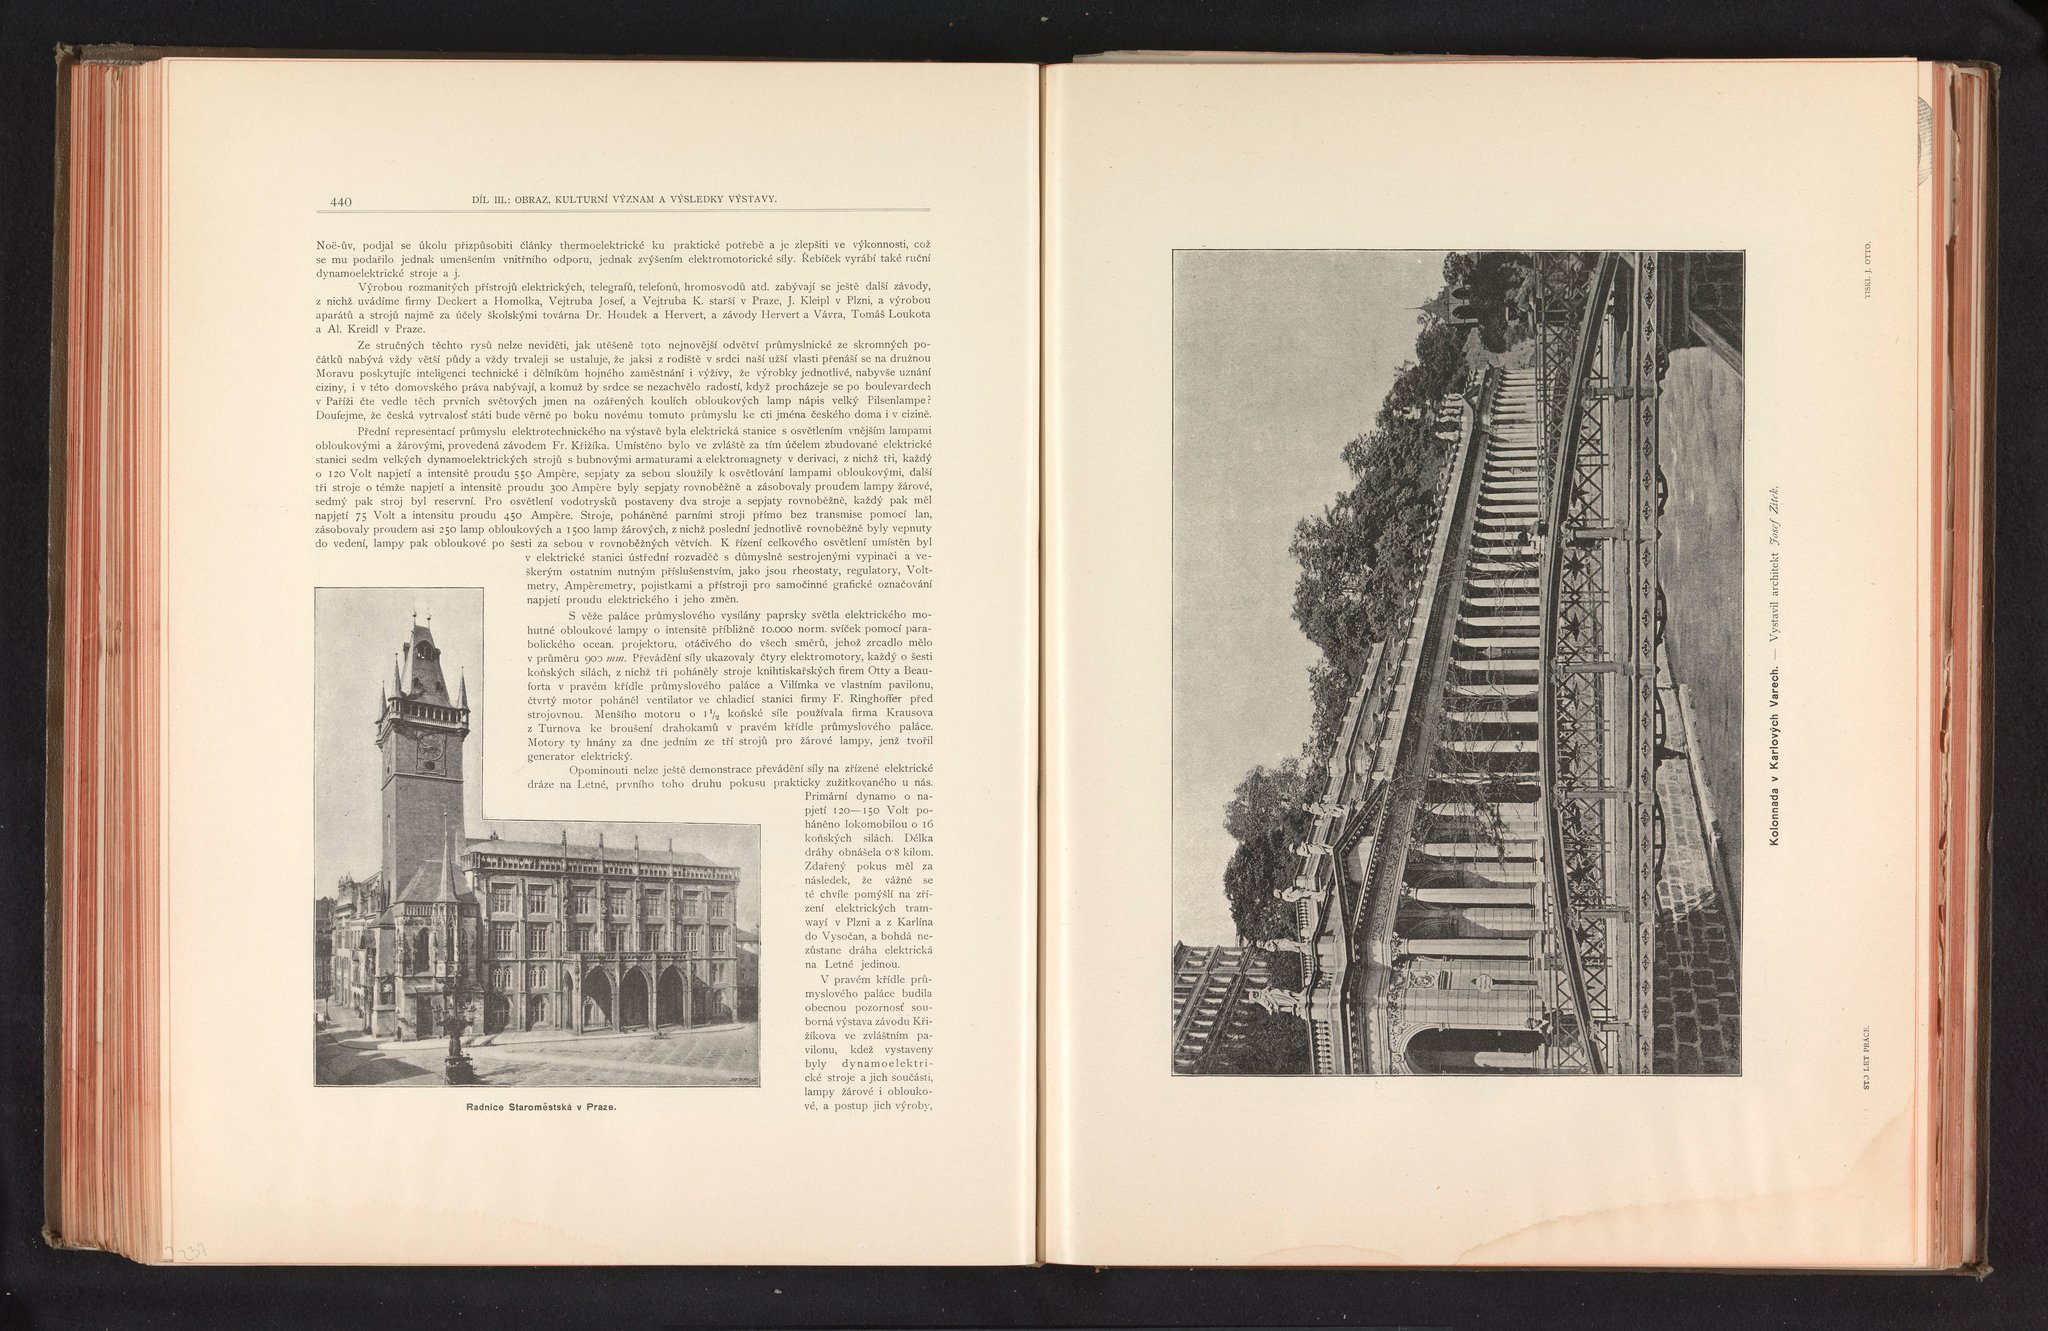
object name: photomechanical print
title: Zuilenrij te Karlsbad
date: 1891-1895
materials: paper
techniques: autotype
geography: prague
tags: colonnade, façade (of house or building)